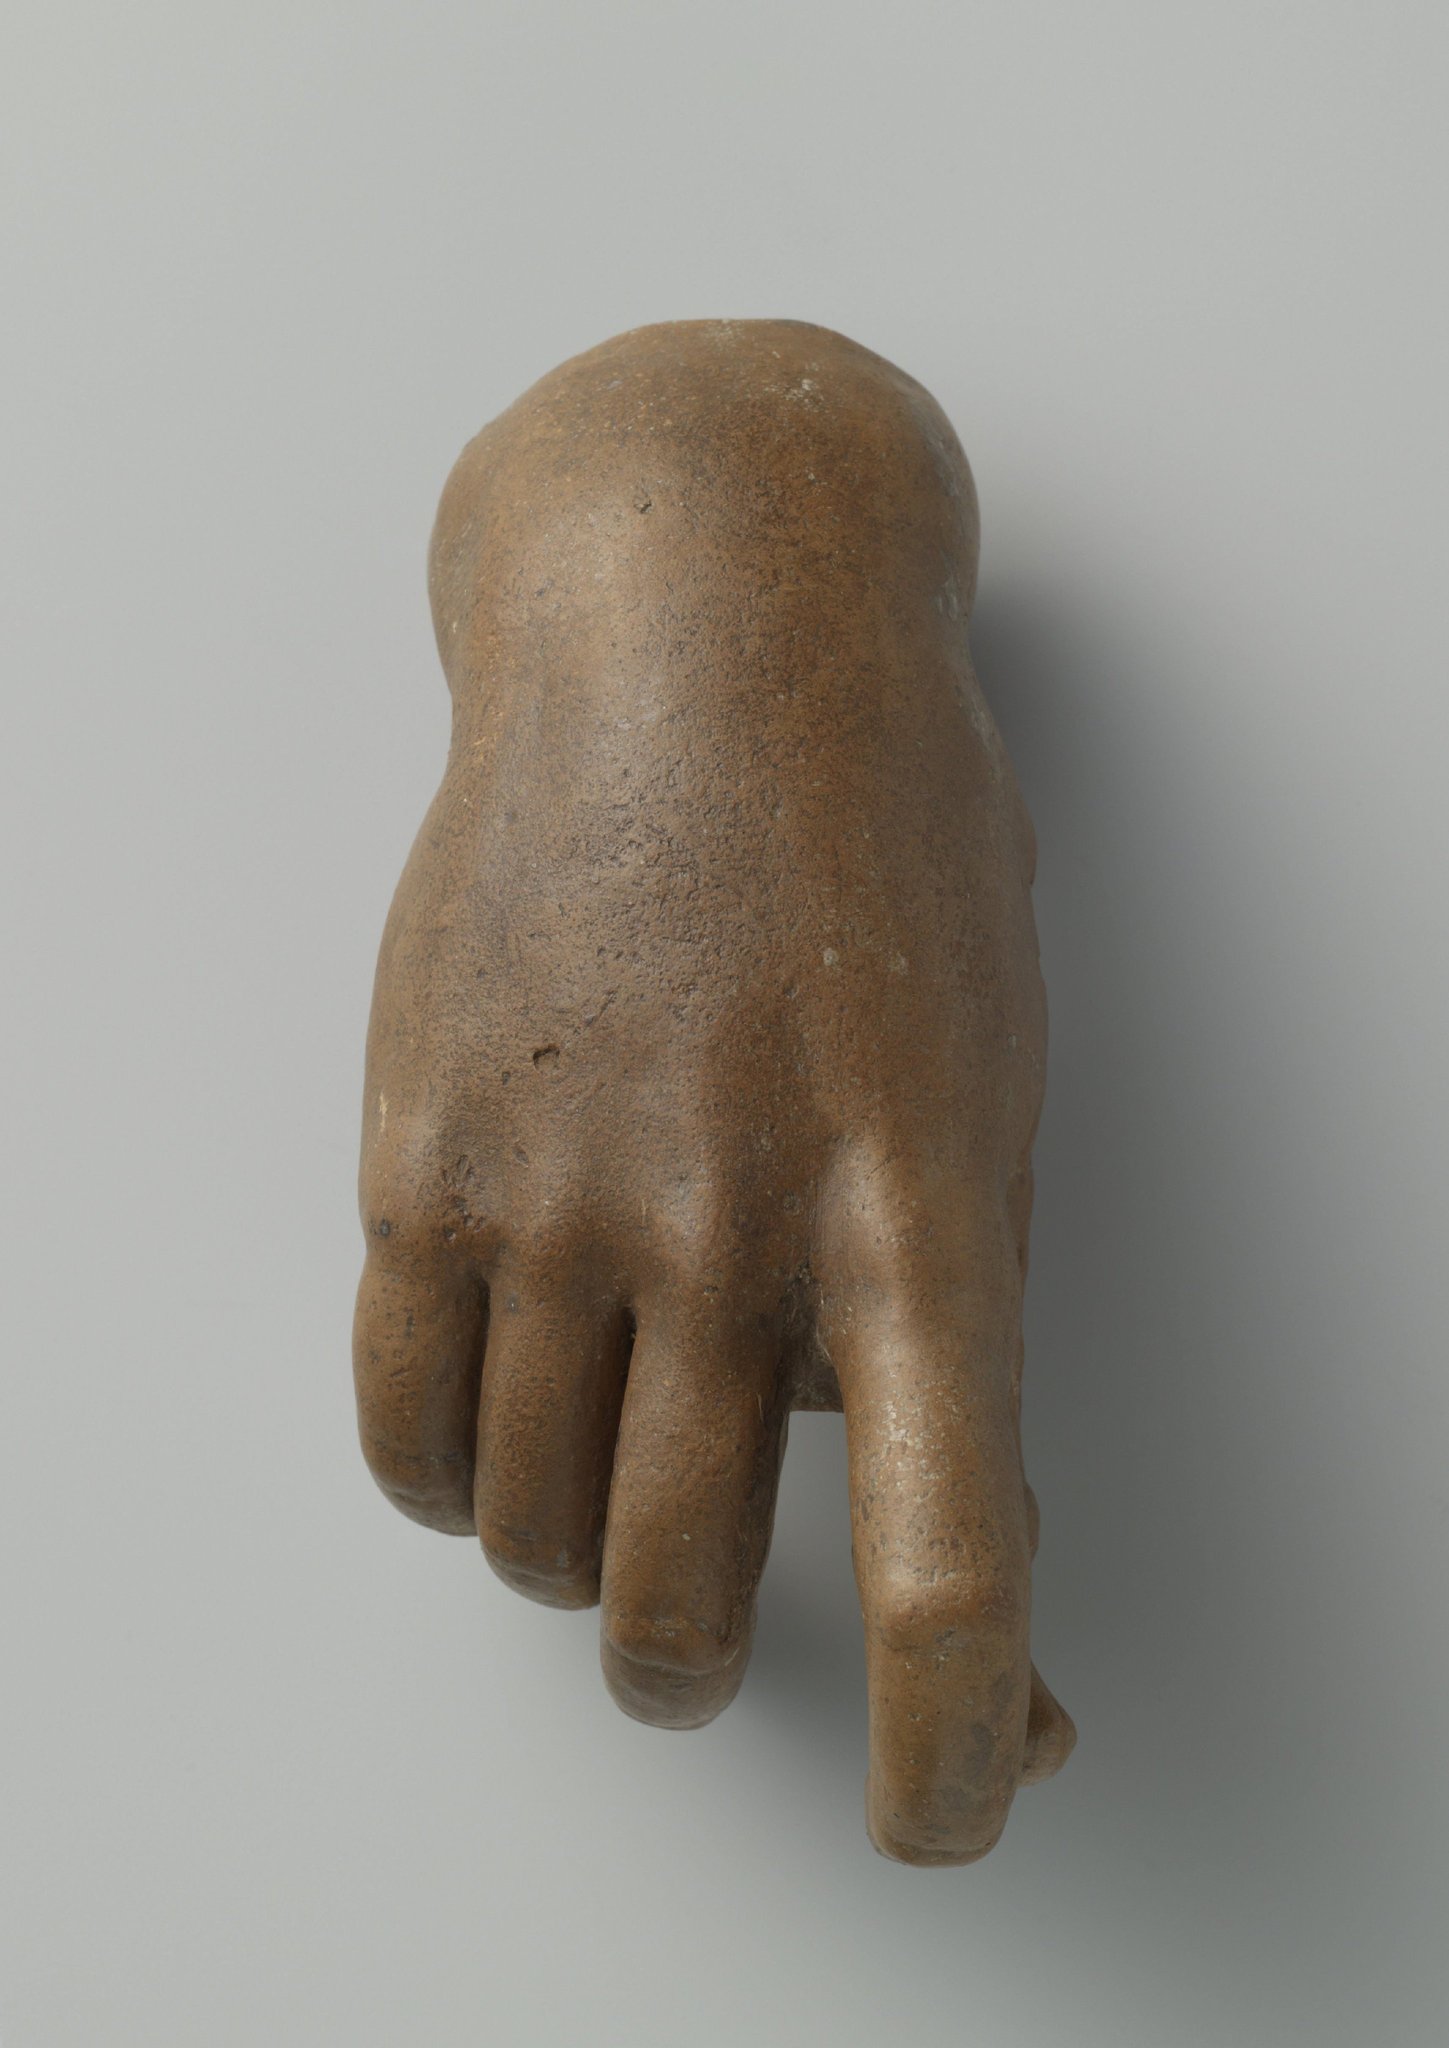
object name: model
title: Sculptor's Mdoel of a Right Hand, after the statue of Lorenzo de’ Medici (Medici Chapel, San Lorenzo, Florence)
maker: johan gregor van der schardt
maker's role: sculptor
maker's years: 1530-1581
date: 1560-1570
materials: terracotta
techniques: molding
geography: florence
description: This group of small models of parts of the body are carefully copied after famous sculptures, in particular by Michelangelo, in Florence and Rome. They came from the workshop of the Nijmegen sculptor Johan Gregor van der Schardt, who had a successful career in Italy, Nuremberg, and Copenhagen. They are extremely rare examples of the, in part autograph, study material of a 16th-century sculptor.